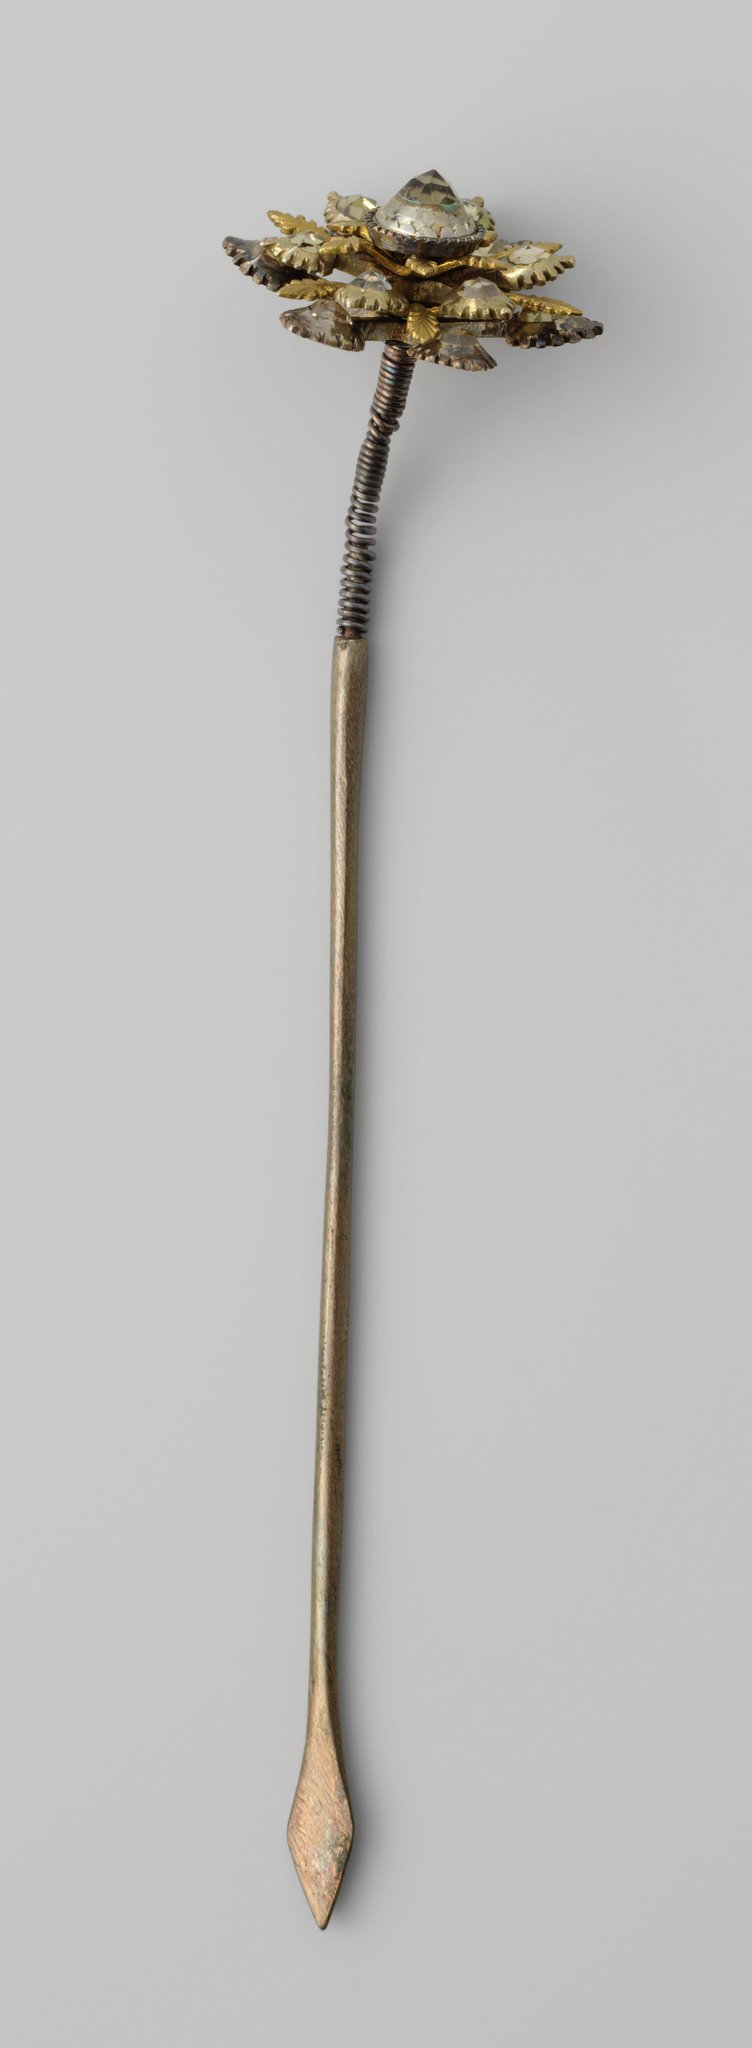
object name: hoofdsieraad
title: Haarnaald van (verguld )zilver met dertien imitatiediamanten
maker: Anonymous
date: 1700-1800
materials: silver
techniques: gilding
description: Haarnaald van gedeeltelijk verguld zilver met één grote en verschillende kleinere imitatie edelstenen. De stenen zijn van glas en voorzien van een rooslijpsel om diamant te imiteren. De glasstenen zijn in drie, afhankelijk van elkaar draaiende, onderdelen gezet. De drie delen zijn met palmetmotieven versierd.